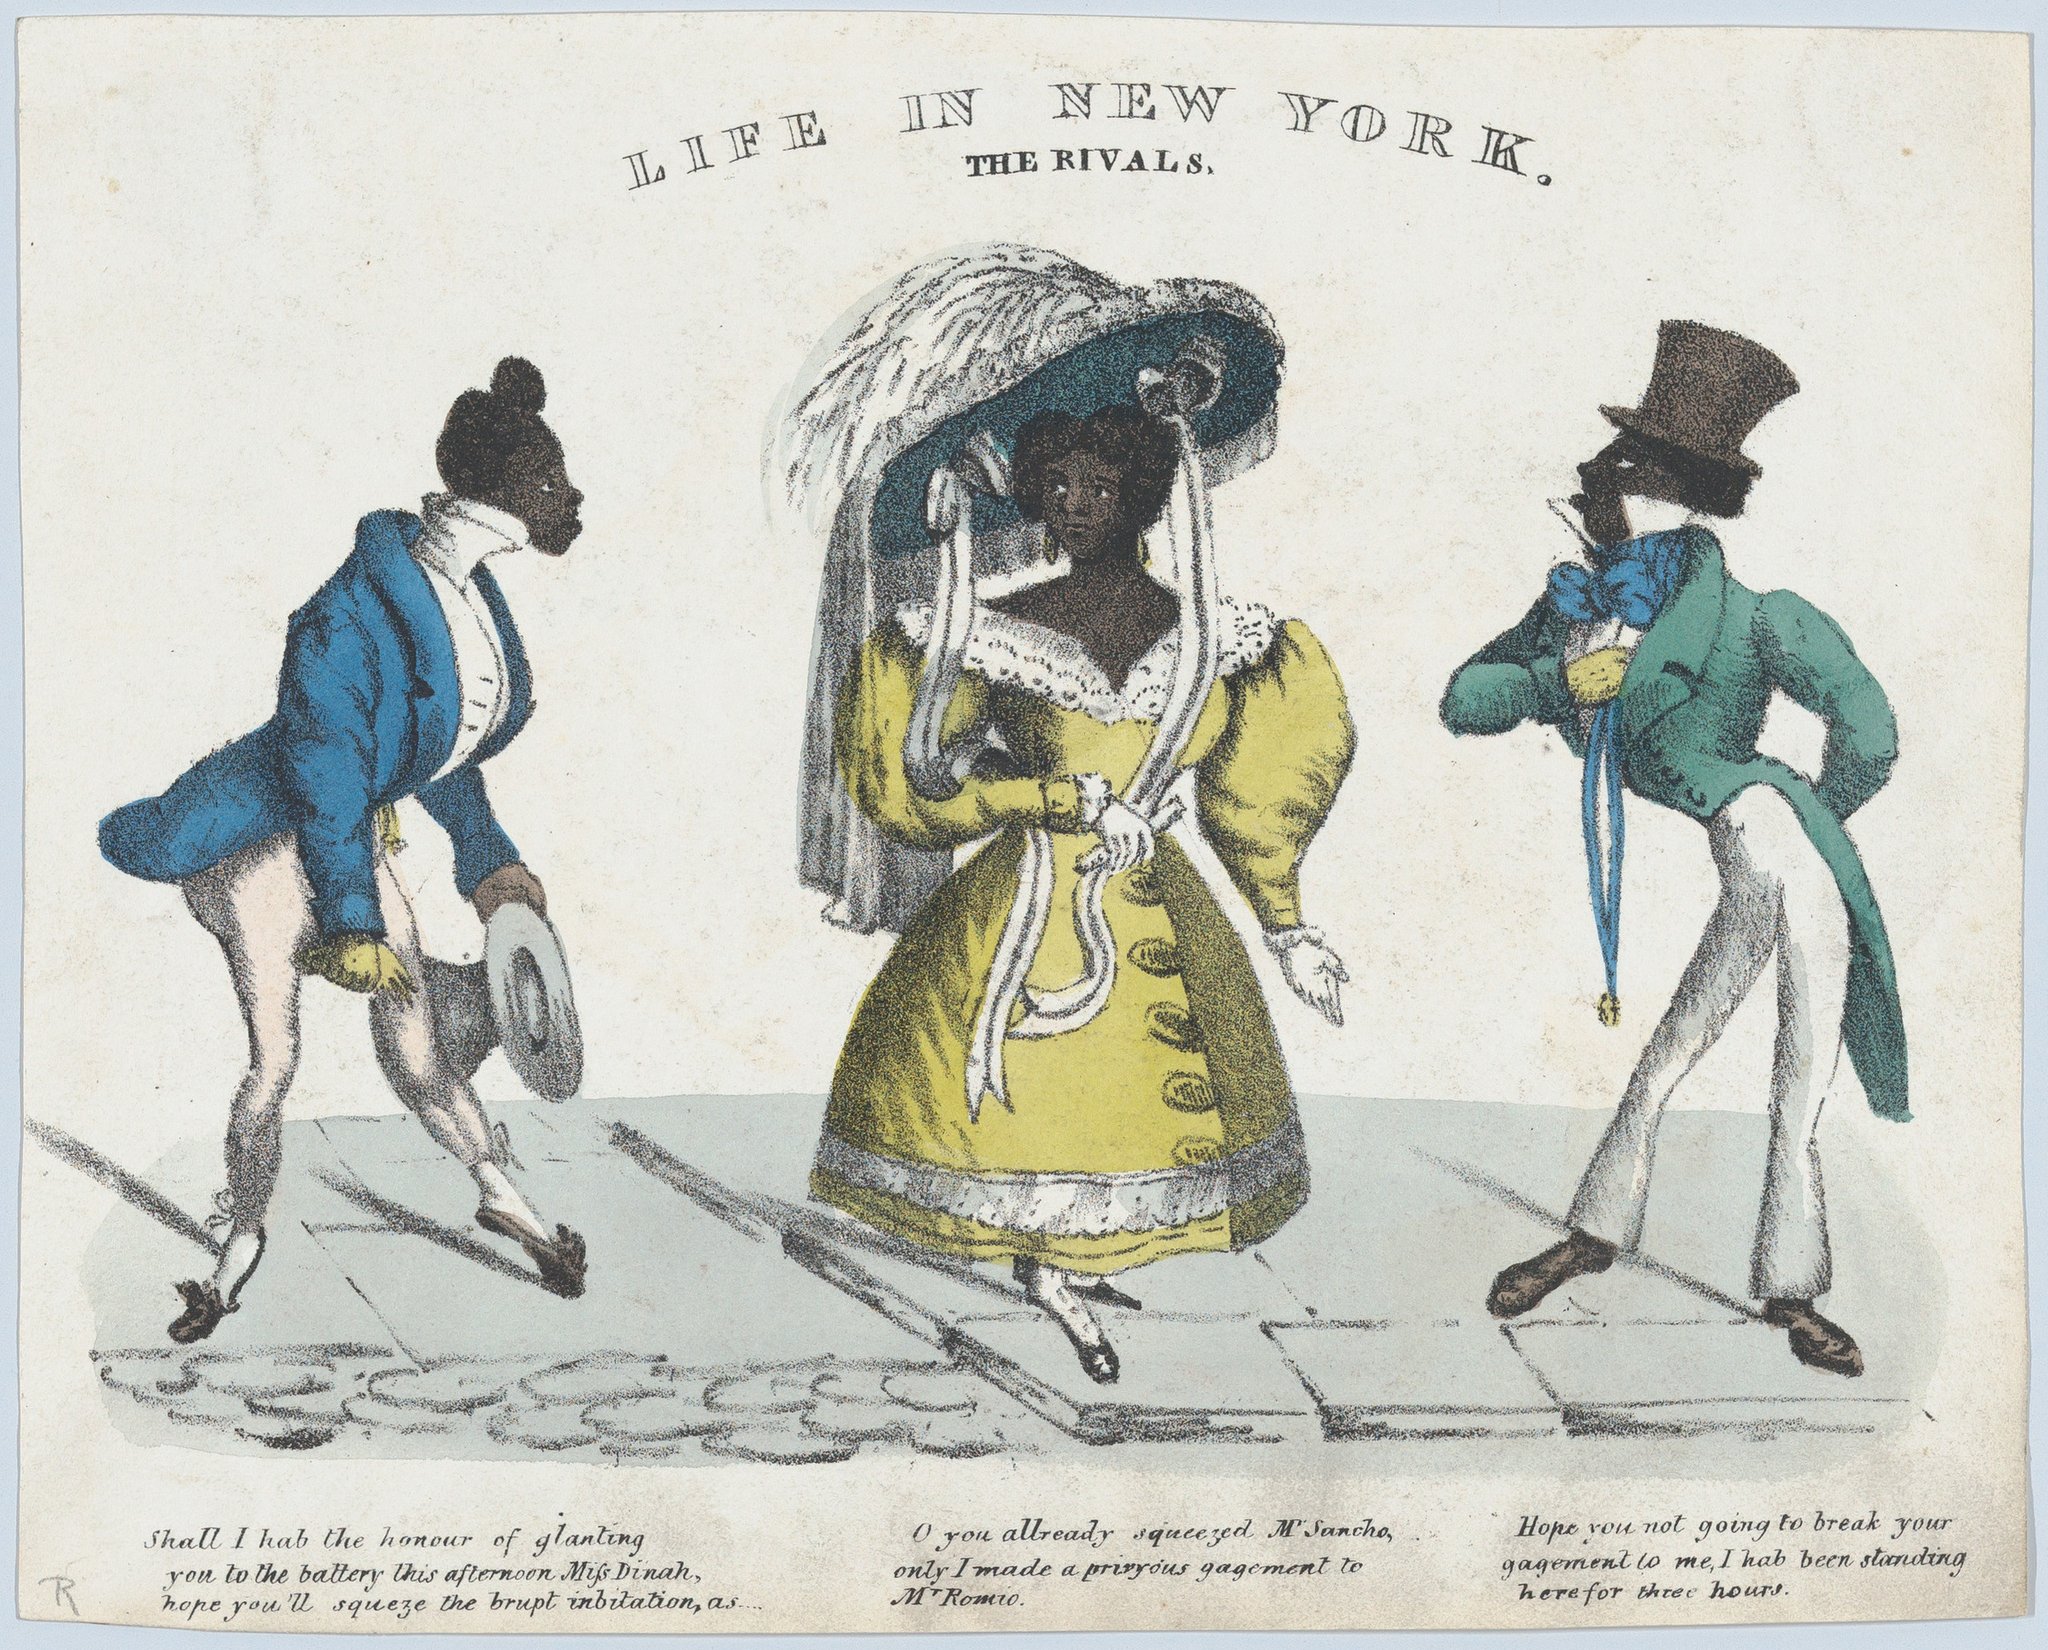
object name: print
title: Life in New York. The Rivals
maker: w. harrison isaacs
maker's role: publisher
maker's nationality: british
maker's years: 1825-1832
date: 1831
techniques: hand coloring, lithograph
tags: hats,men,women